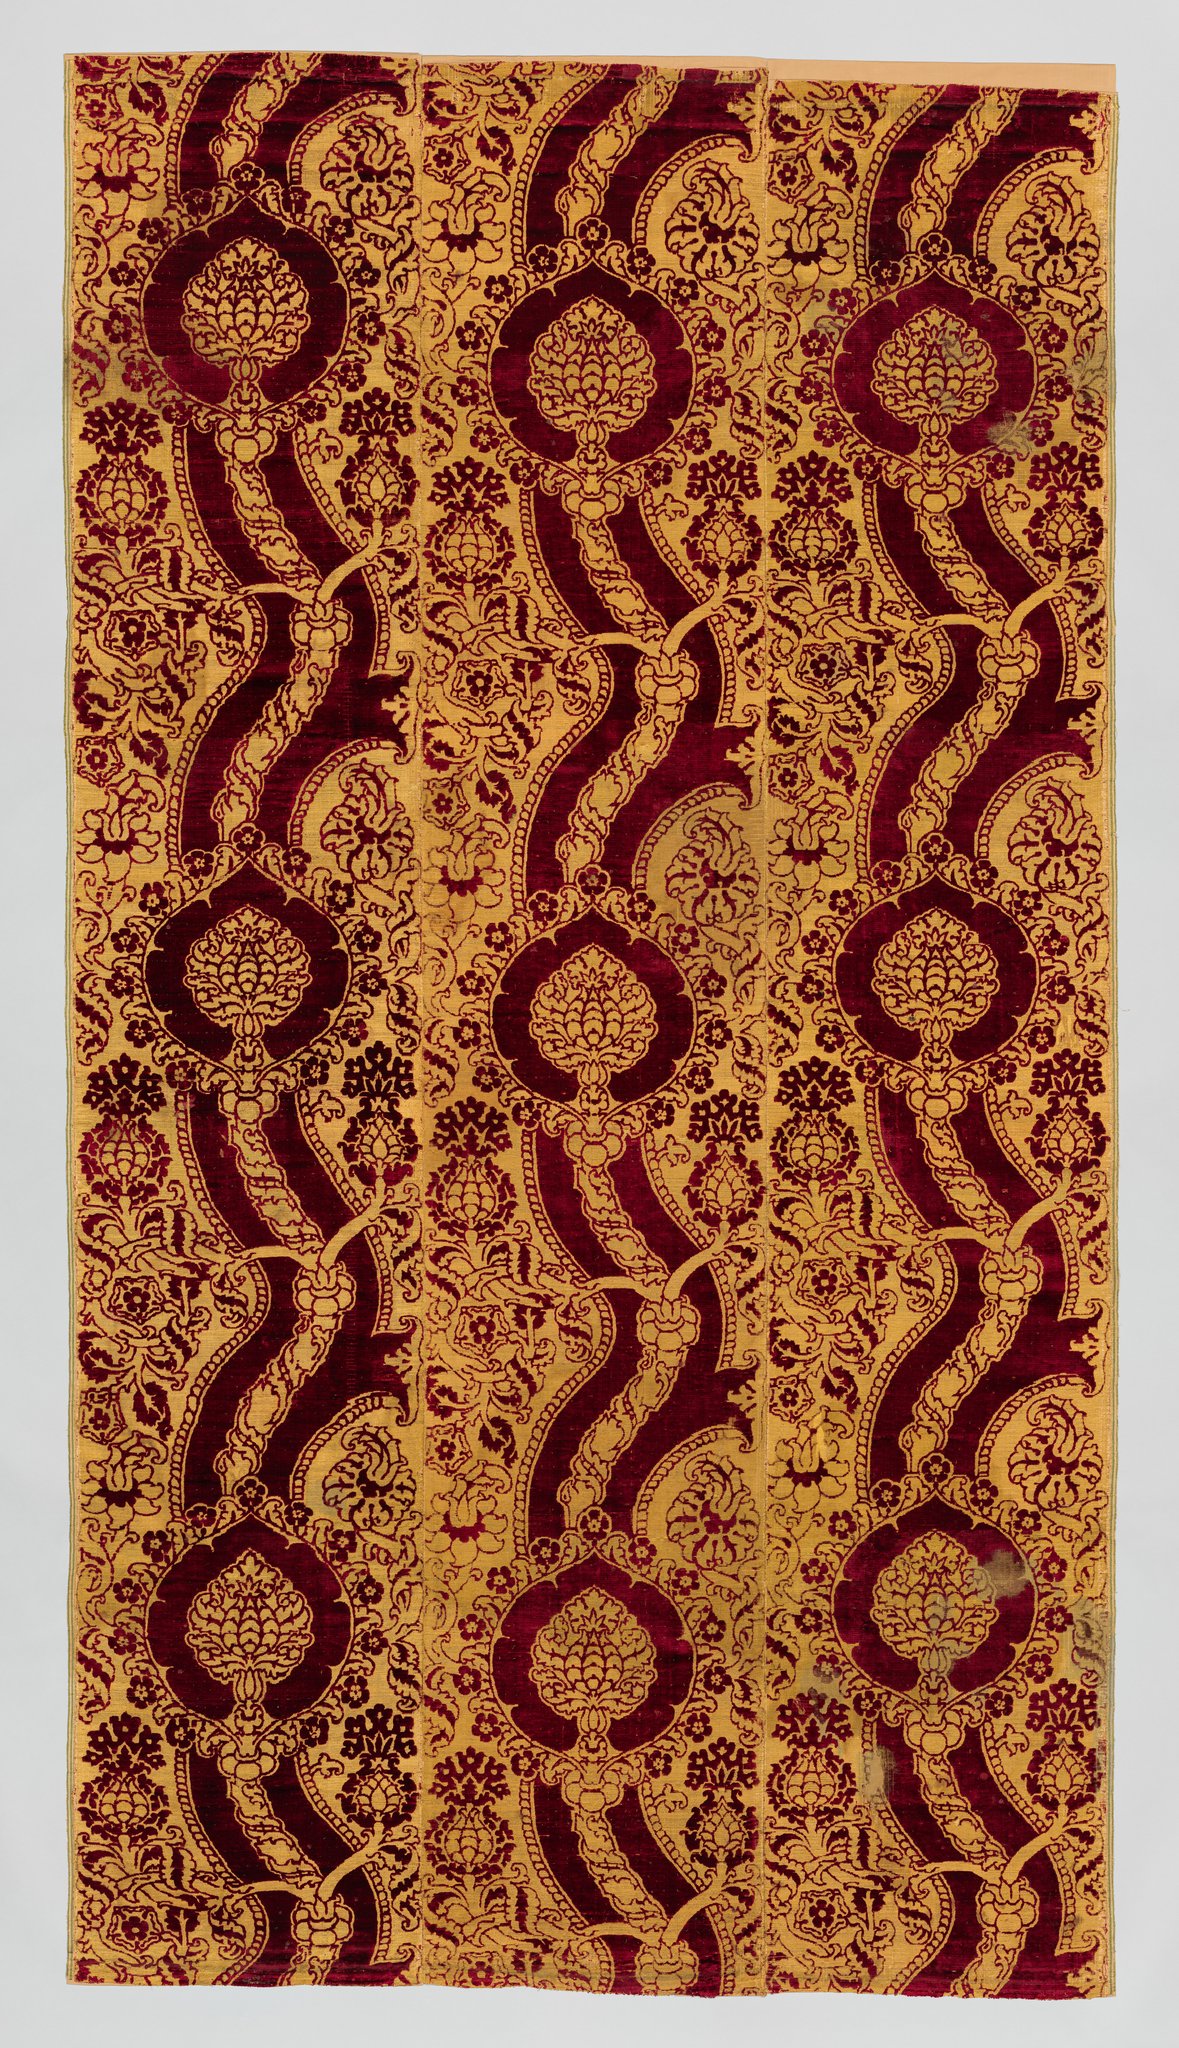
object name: wall hanging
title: Furnishing Textile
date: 1467-1566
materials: textile, gilt silver, gold, metal, thread, velvet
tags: flowers